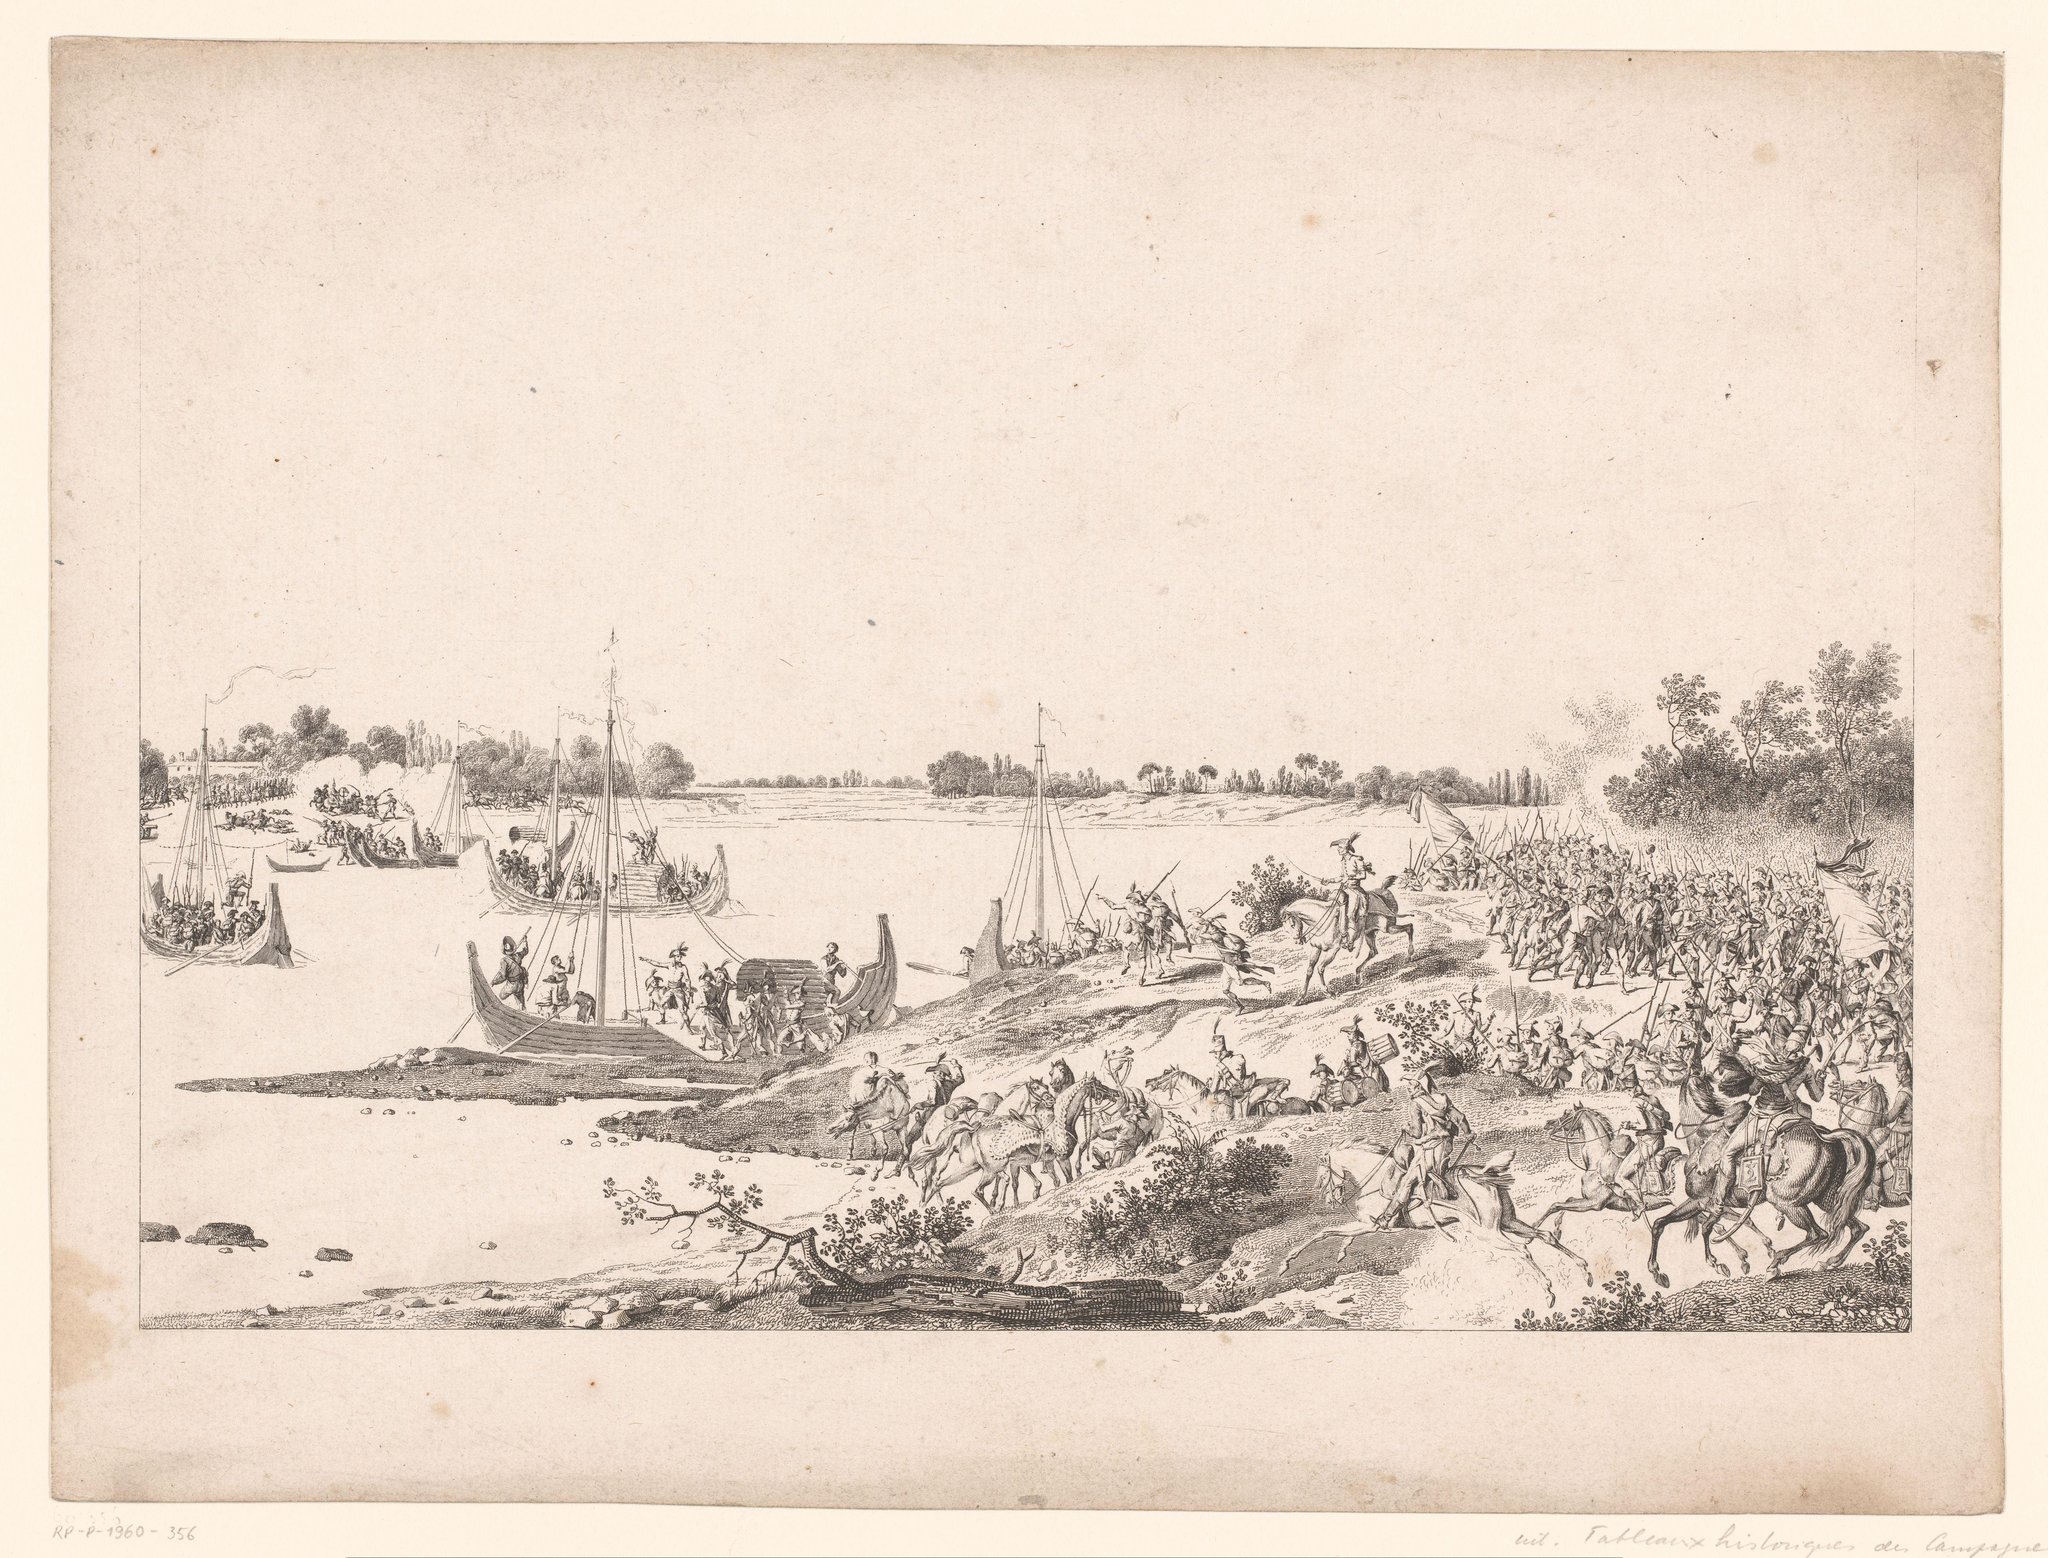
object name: print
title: Landschap met cavalerie aan het water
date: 1799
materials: paper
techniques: etching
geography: france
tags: army 'en route', water course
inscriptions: inscription: ‘a paris chez Naudet [...] 1890 f’, collector's mark: Lugt 2228